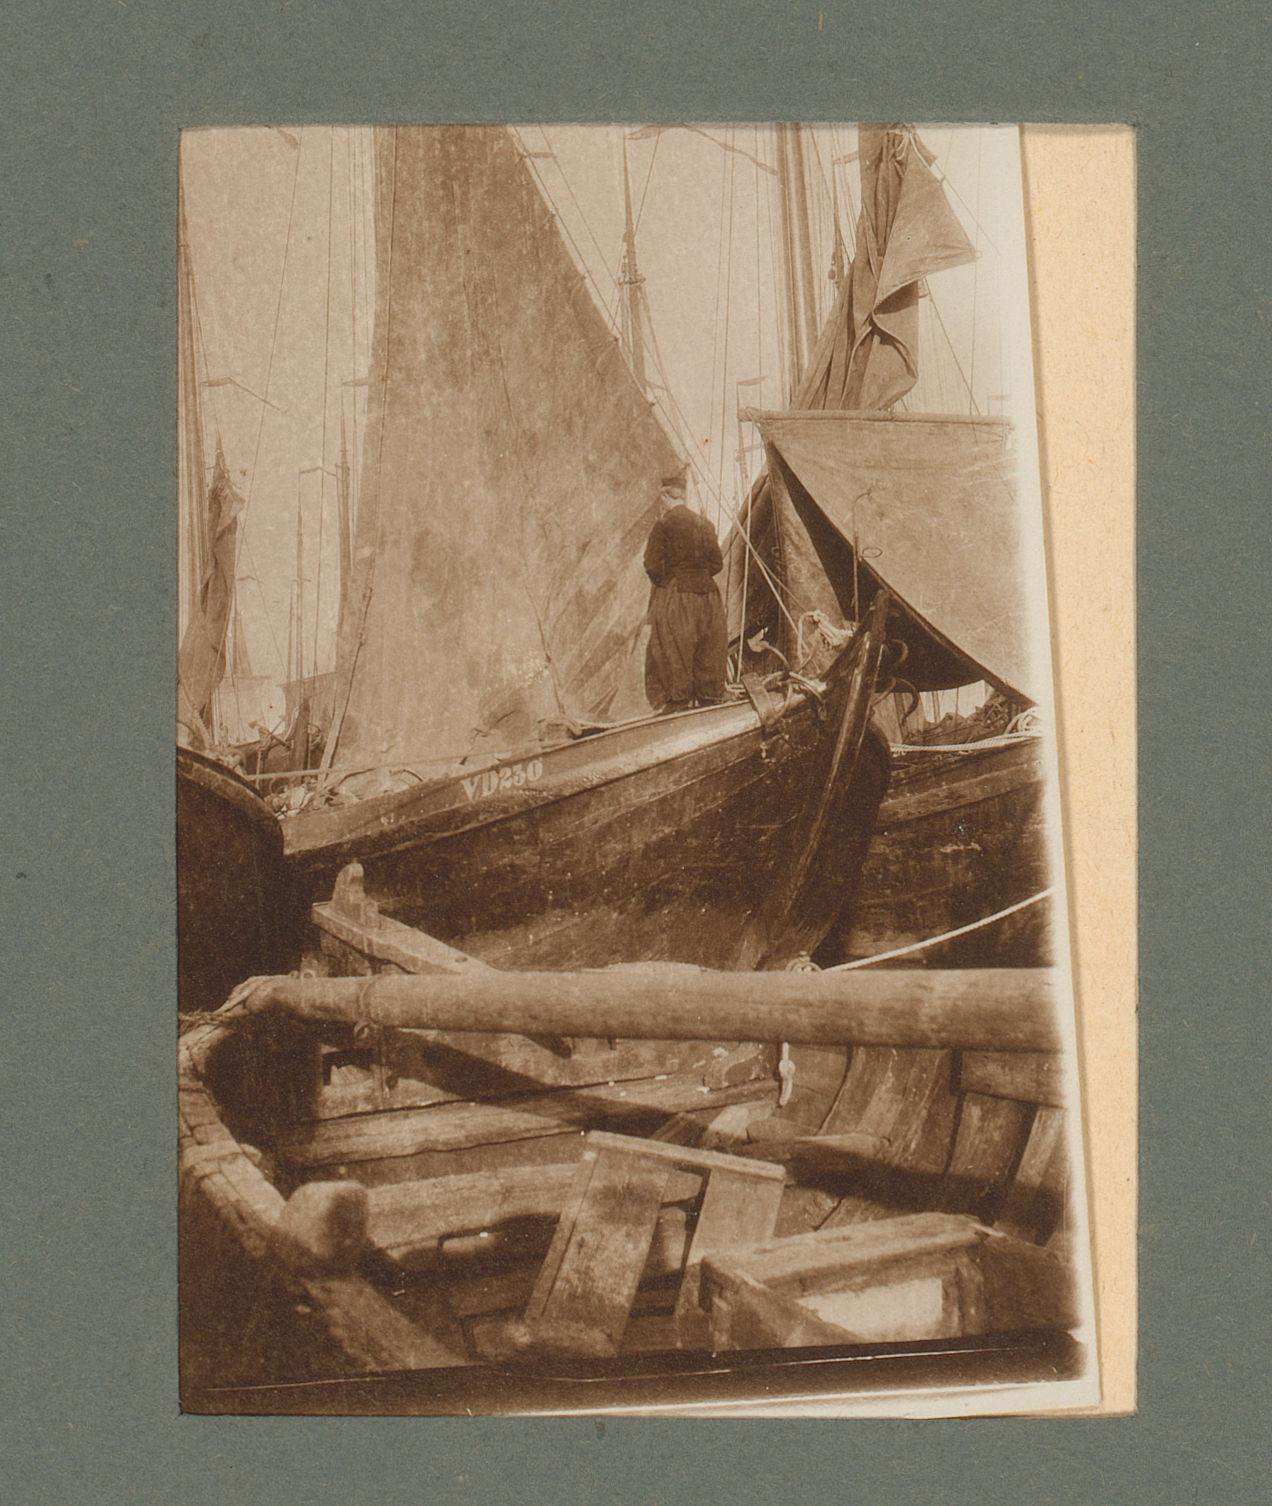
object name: photograph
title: Man in klederdracht, staande op een zeilboot in Volendam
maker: george hidderley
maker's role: fotograaf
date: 1920-1940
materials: photographic support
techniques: daylight paper print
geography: volendam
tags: sailing-ship, sailing-boat, adult man, historical persons, folk costume, regional costume